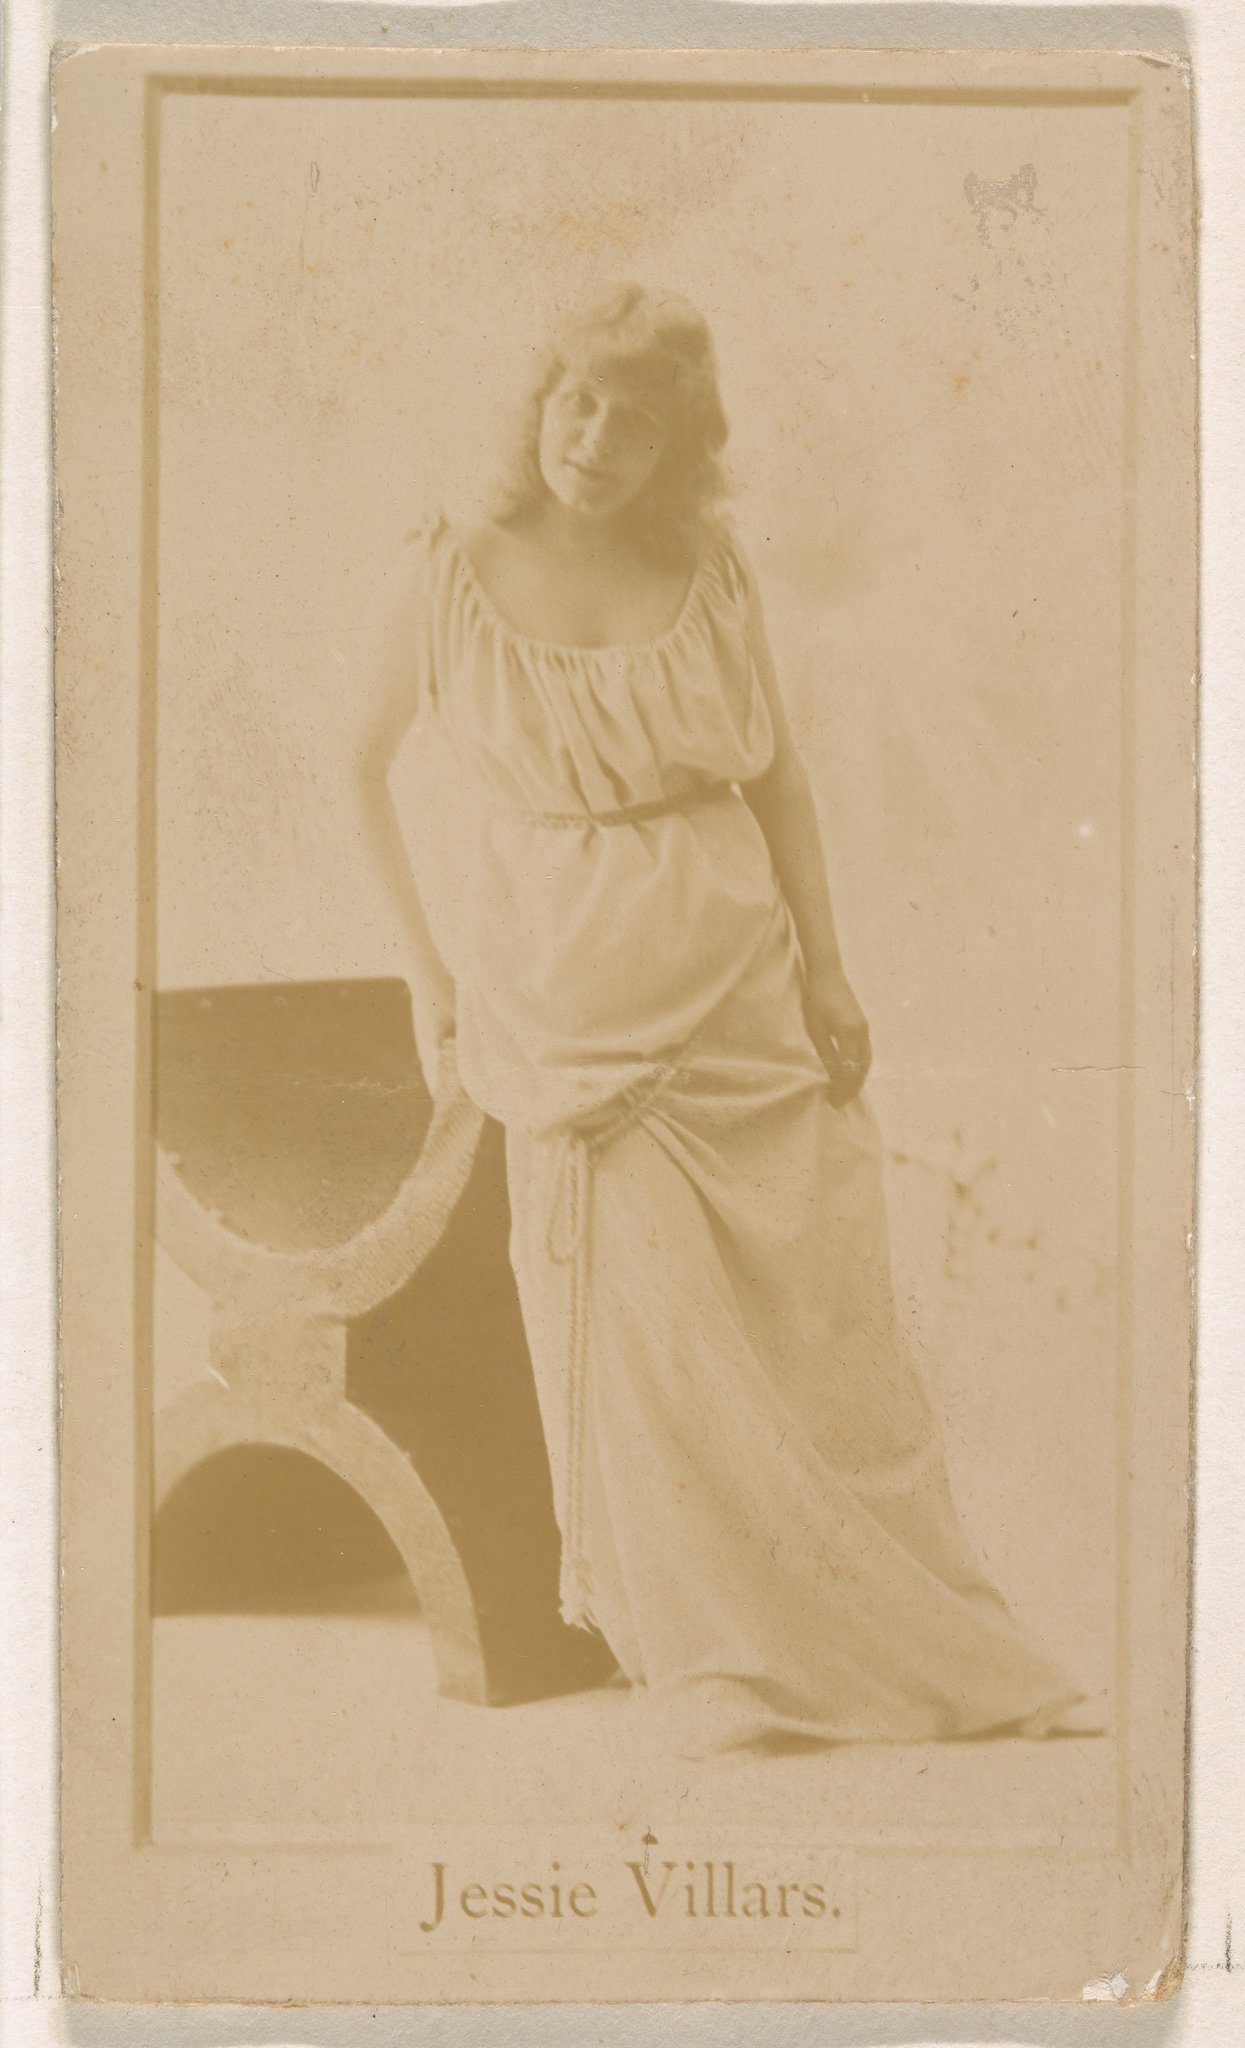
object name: photograph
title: Jessie Villars, from the Actresses series (N245) issued by Kinney Brothers to promote Sweet Caporal Cigarettes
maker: kinney brothers tobacco company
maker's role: publisher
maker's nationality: american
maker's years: 1869-2011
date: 1890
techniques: albumen silver print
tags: portraits,women,actresses